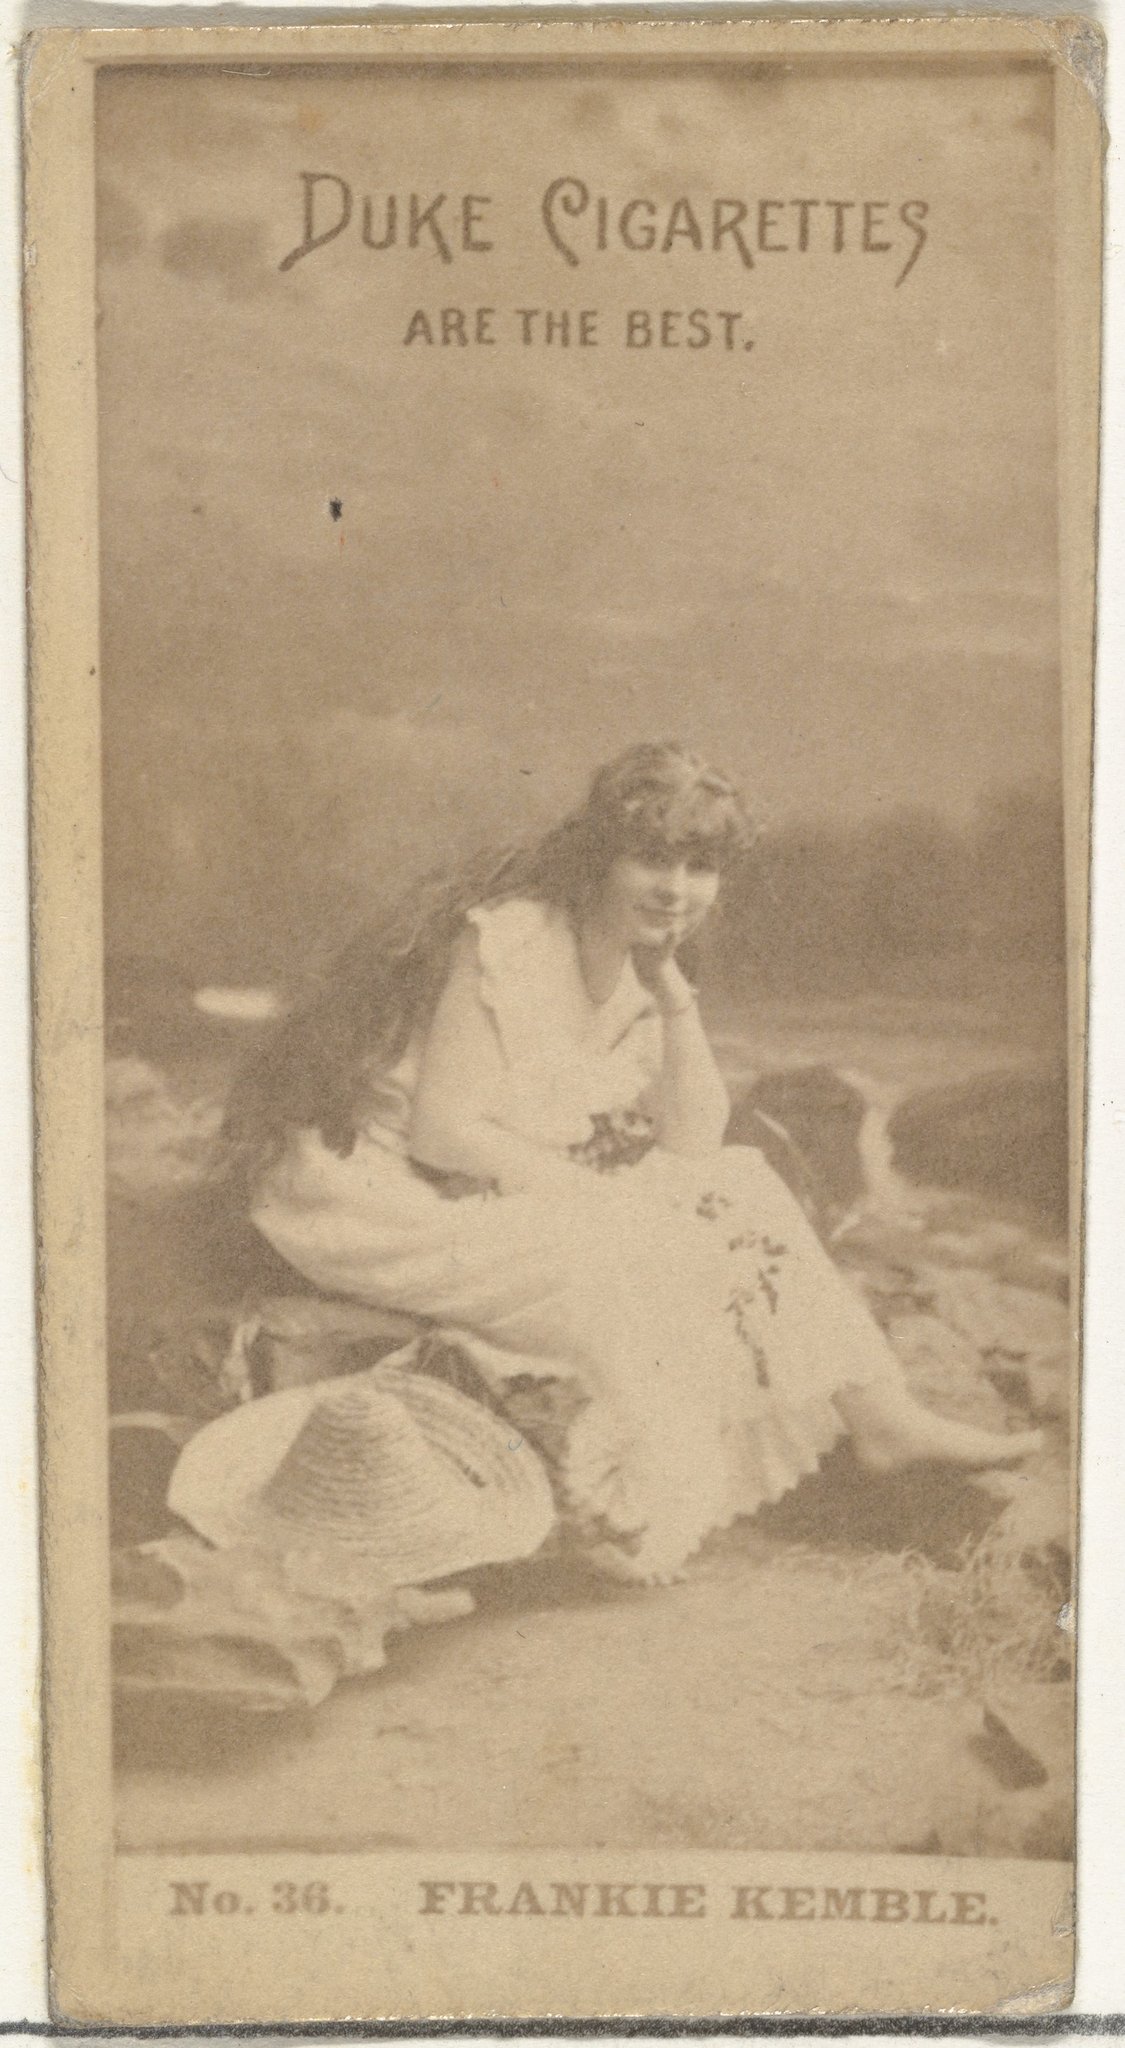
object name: photograph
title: Card Number 36, Frankie Kemble, from the Actors and Actresses series (N145-6) issued by Duke Sons & Co. to promote Duke Cigarettes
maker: w. duke, sons & co.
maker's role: publisher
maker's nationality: american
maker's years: 1870-1920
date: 1880-1889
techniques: albumen silver print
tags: portraits,women,actresses